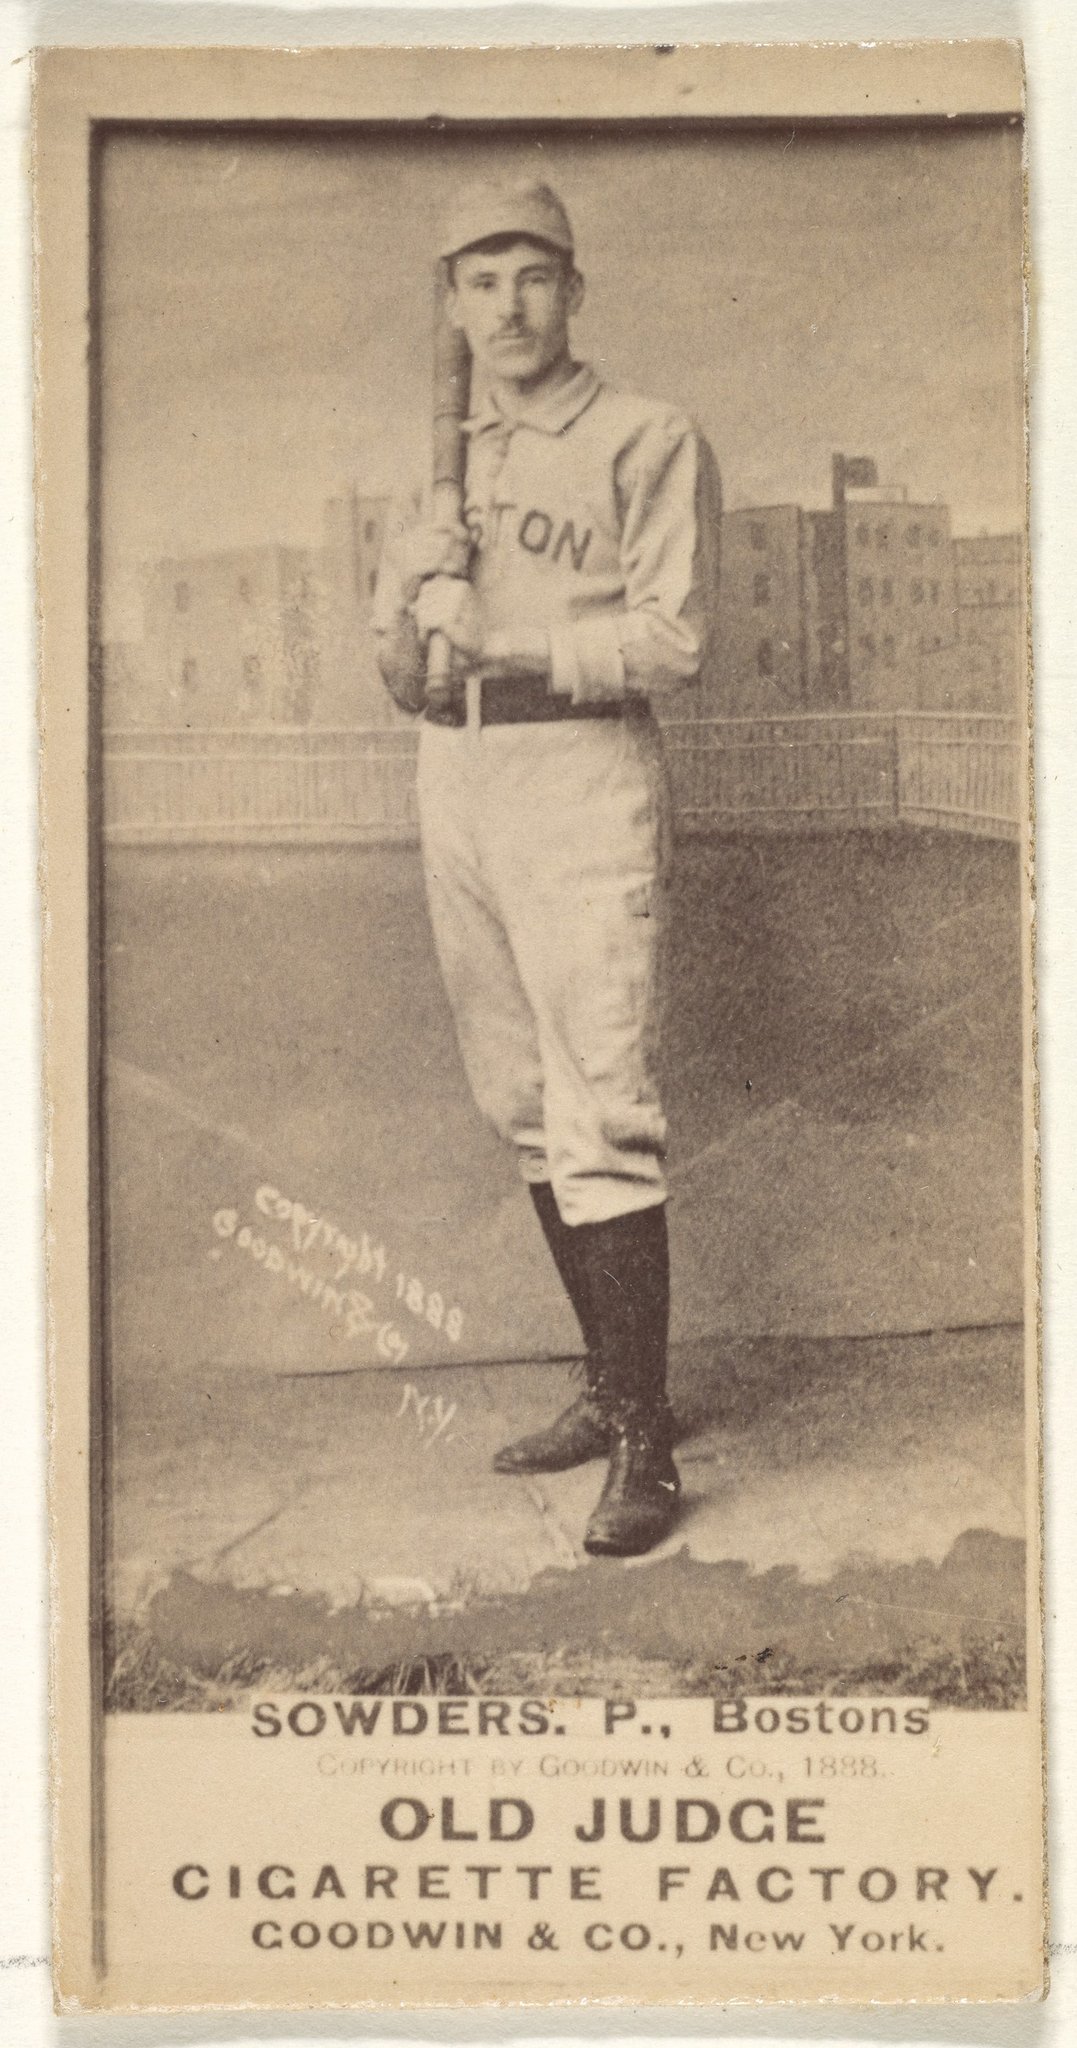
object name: baseball card, photograph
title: Sowders, Pitcher, Boston, from the Old Judge series (N172) for Old Judge Cigarettes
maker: goodwin & company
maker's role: publisher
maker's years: 1850-1950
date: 1888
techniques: albumen silver print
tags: men,portraits,baseball,athletes